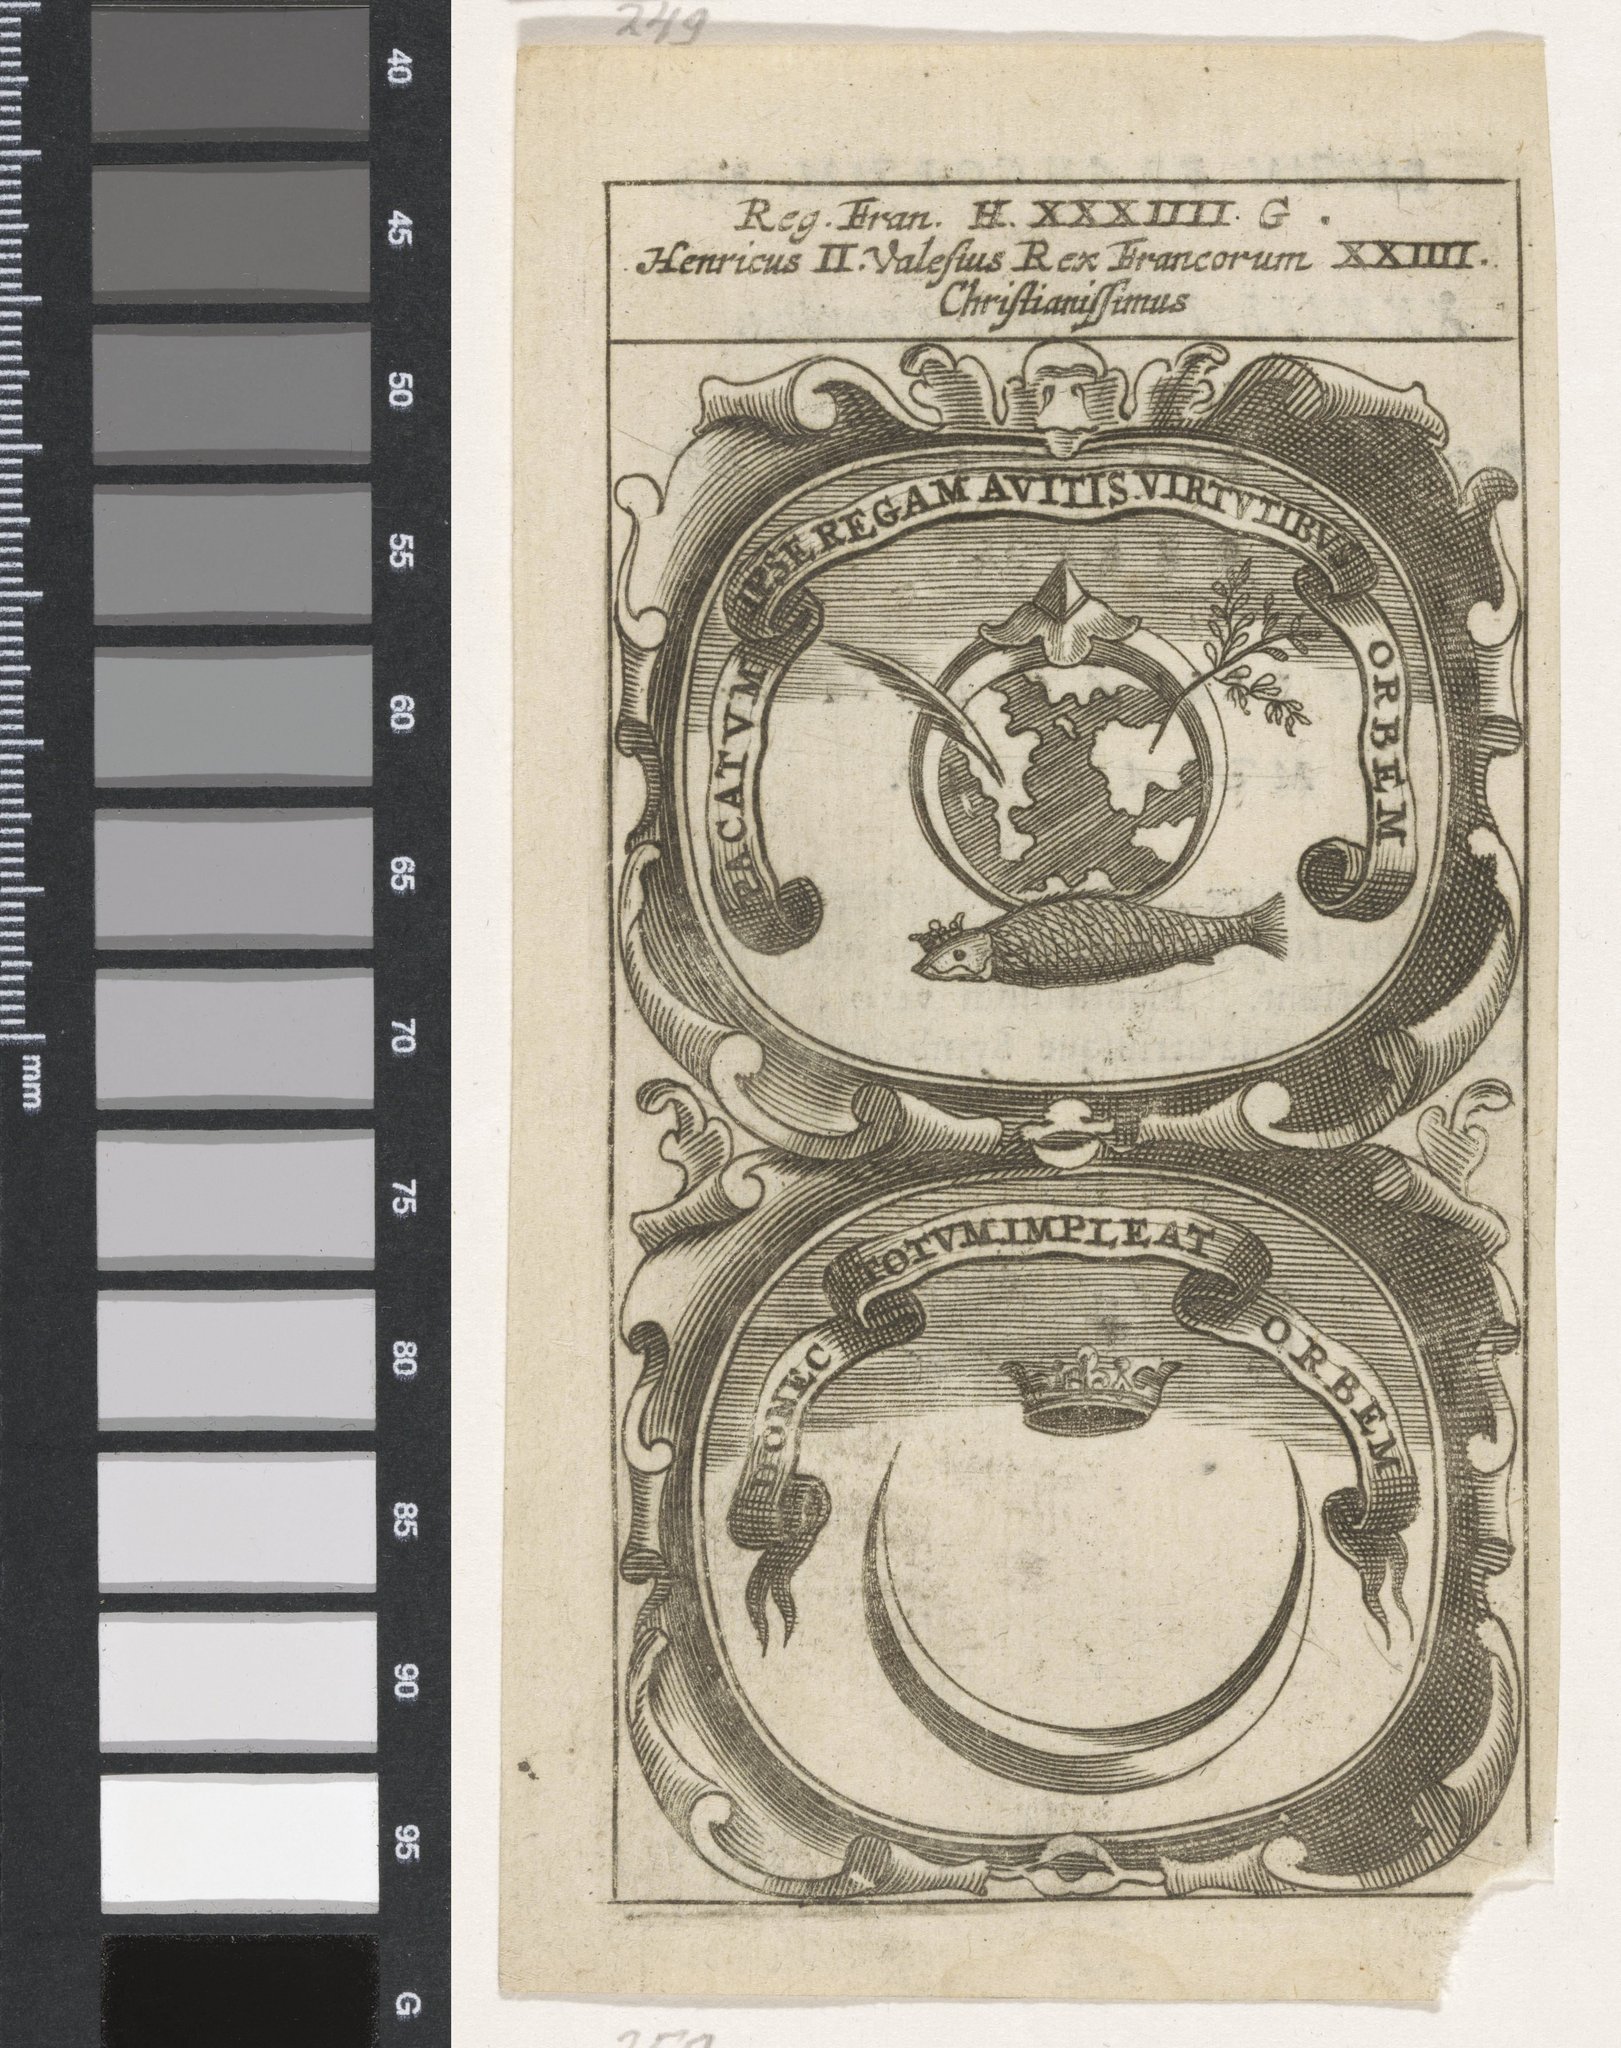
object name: print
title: Ring met wereldbol en gekroonde vis / Halve maan met kroon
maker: Anonymous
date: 1666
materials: paper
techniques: engraving, letterpress printing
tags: paris, earth, world as celestial body, fishes, ring, moon as celestial body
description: Een embleem met twee voorstellingen. Boven een ring met daarin een wereldbol waarin een palmtak en olijftak steken. Daarbij een gekroonde vis. Onder een halve maan met een kroon daarboven. Het betreffen deviezen van Hendrik II van Frankrijk.